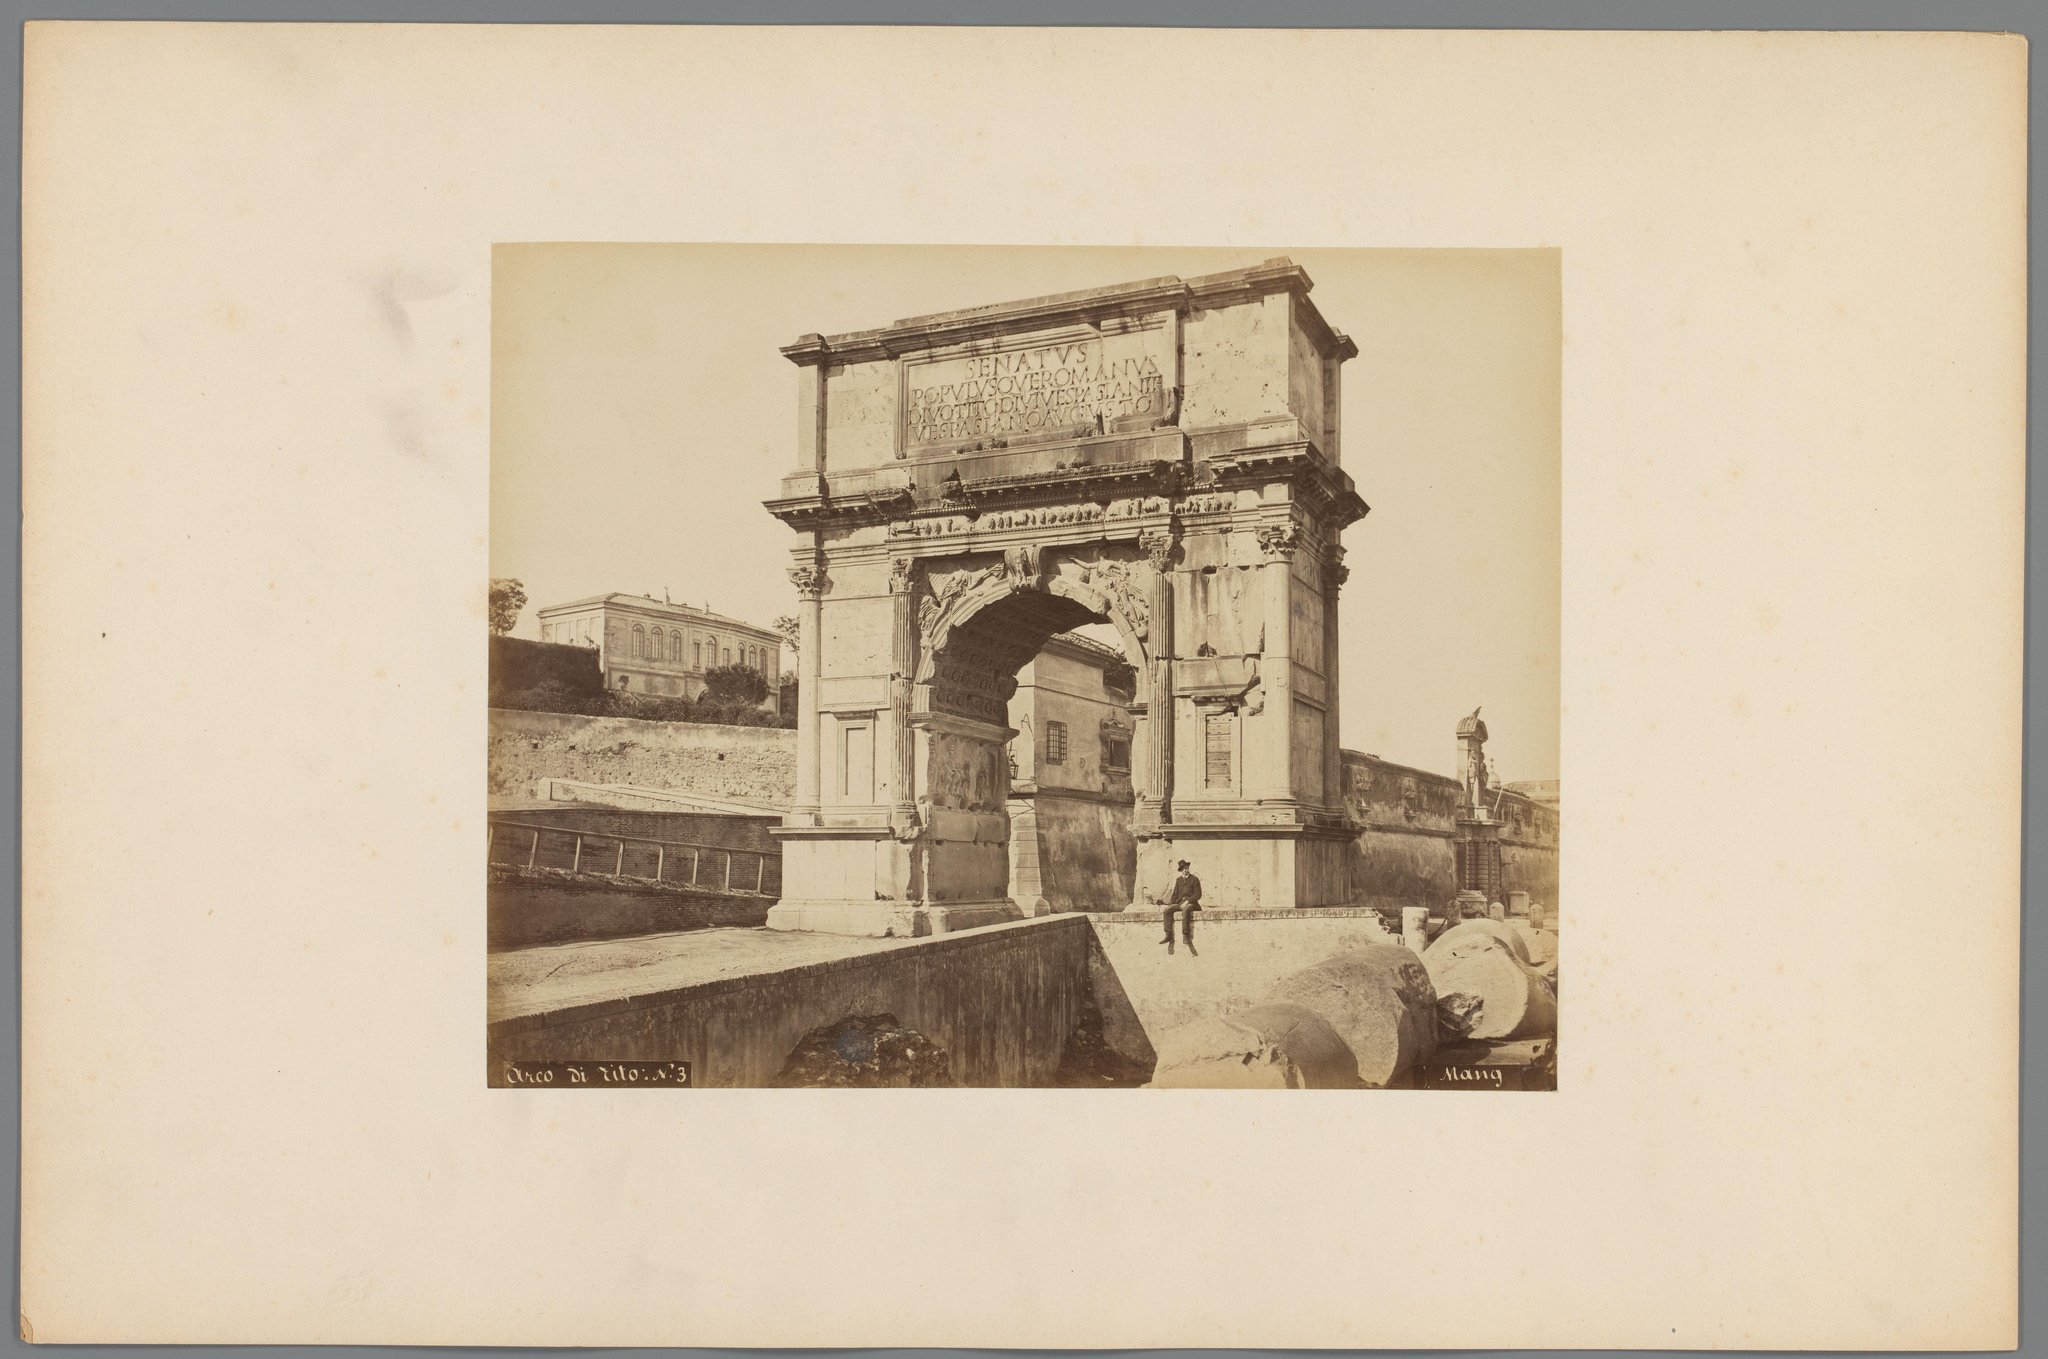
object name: photograph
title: Arco di Tito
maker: michèle mang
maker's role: fotograaf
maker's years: 1840-1909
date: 1863-1887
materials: cardboard, paper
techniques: albumen print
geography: rome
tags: triumphal arch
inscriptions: number: ‘N. 3’